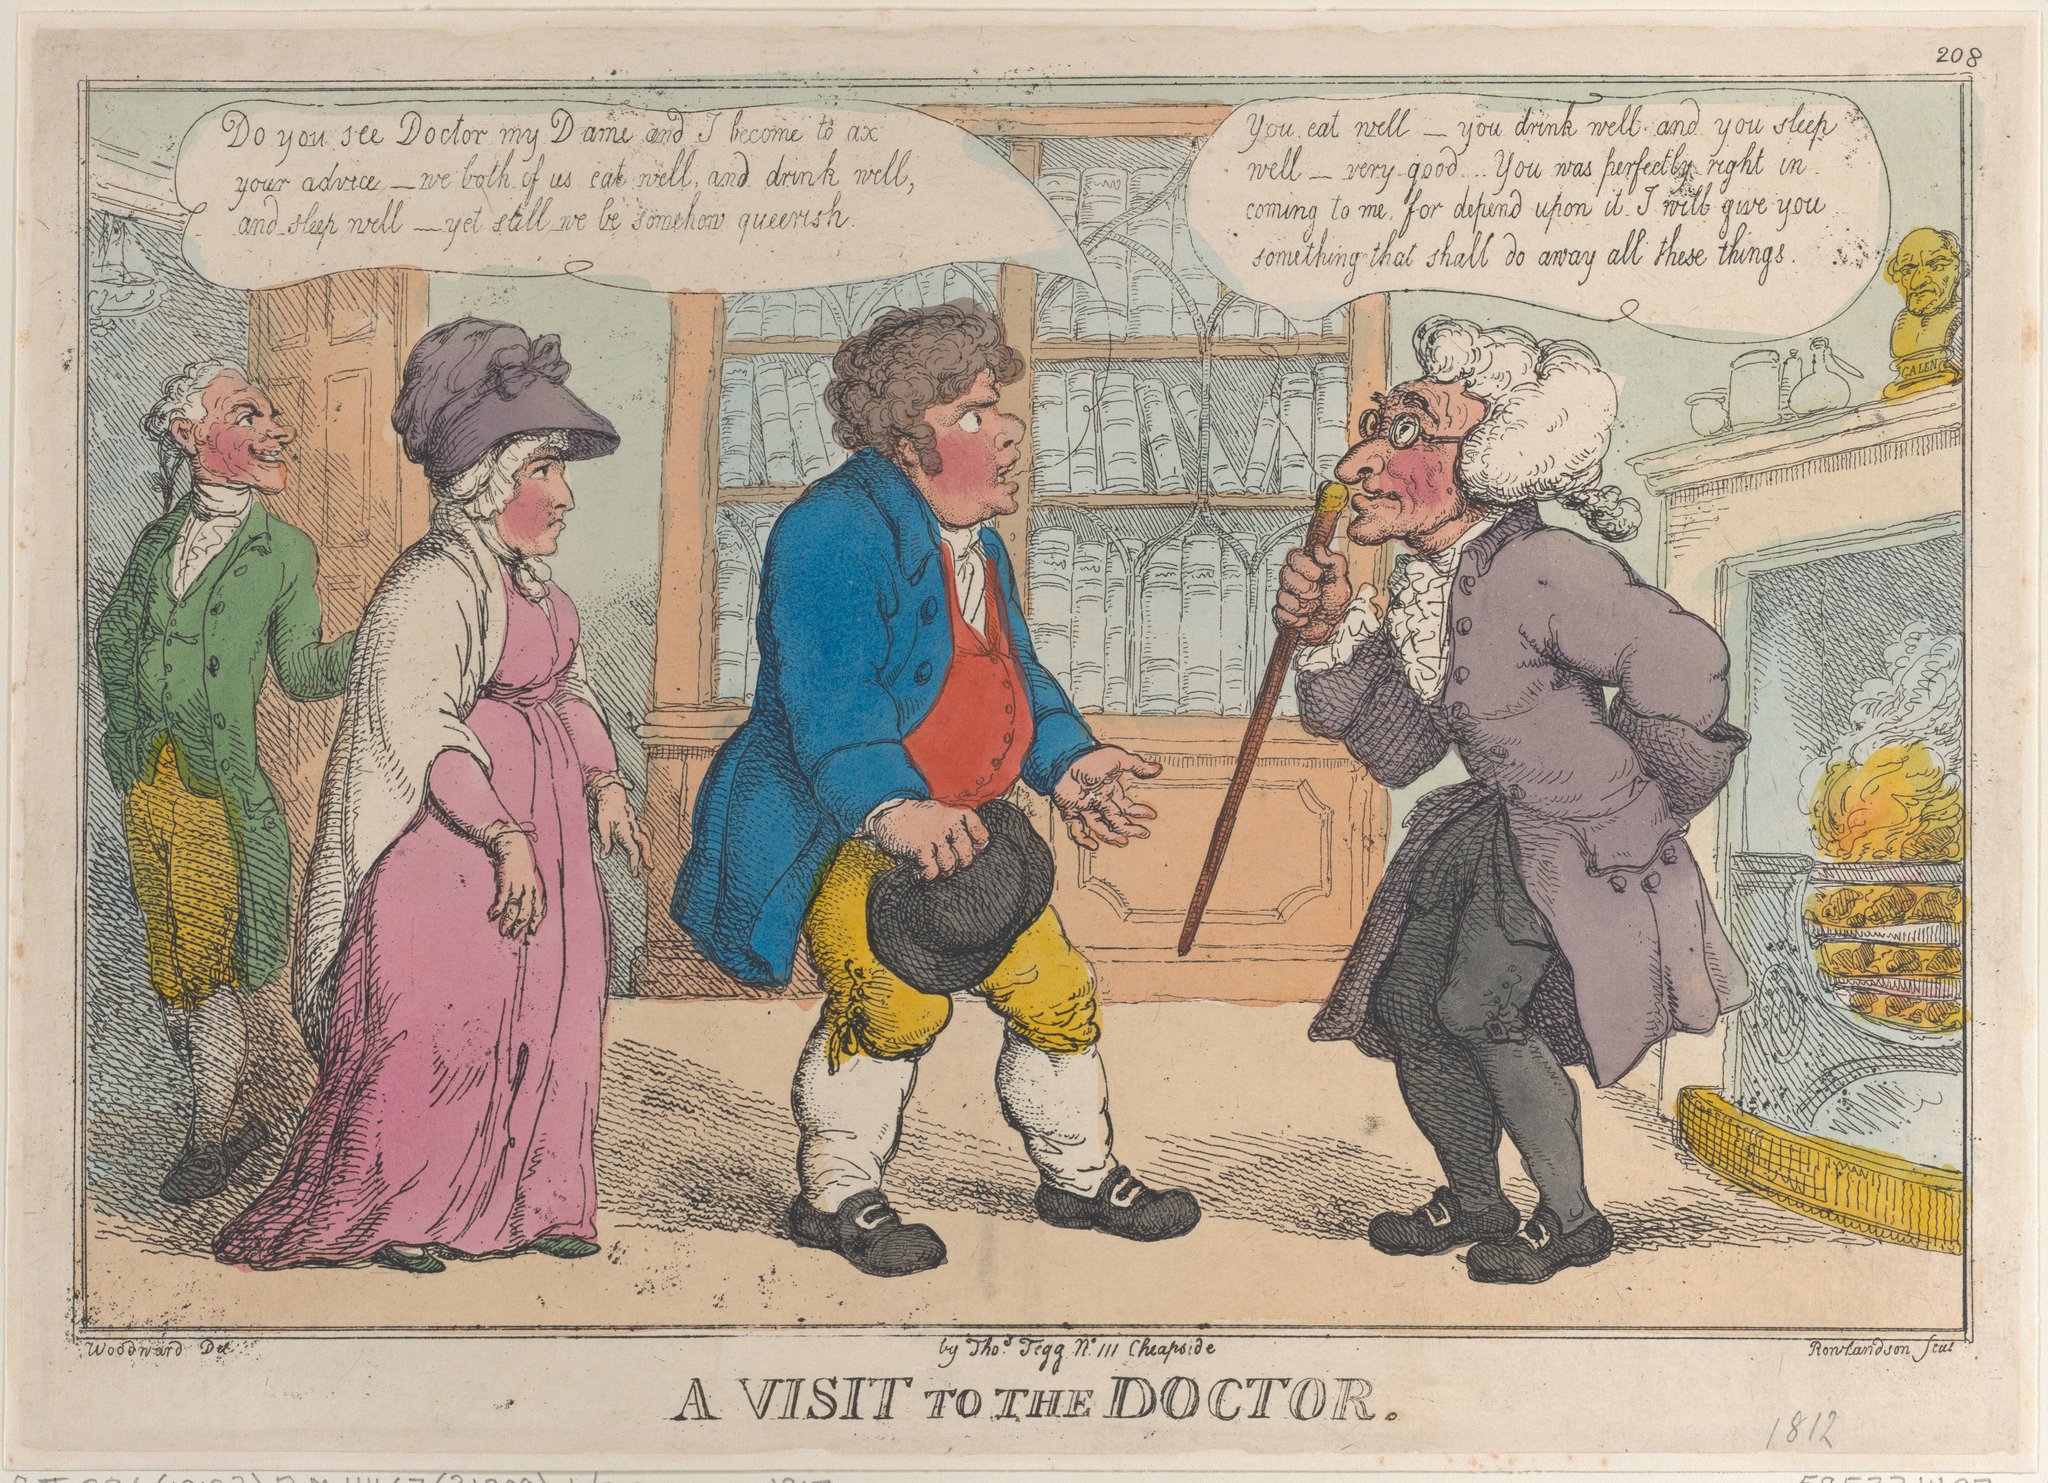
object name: print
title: A Visit to the Doctor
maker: thomas rowlandson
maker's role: artist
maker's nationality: british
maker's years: 1757-1827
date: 1809-1812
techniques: etching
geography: london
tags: satire,men,women,doctors